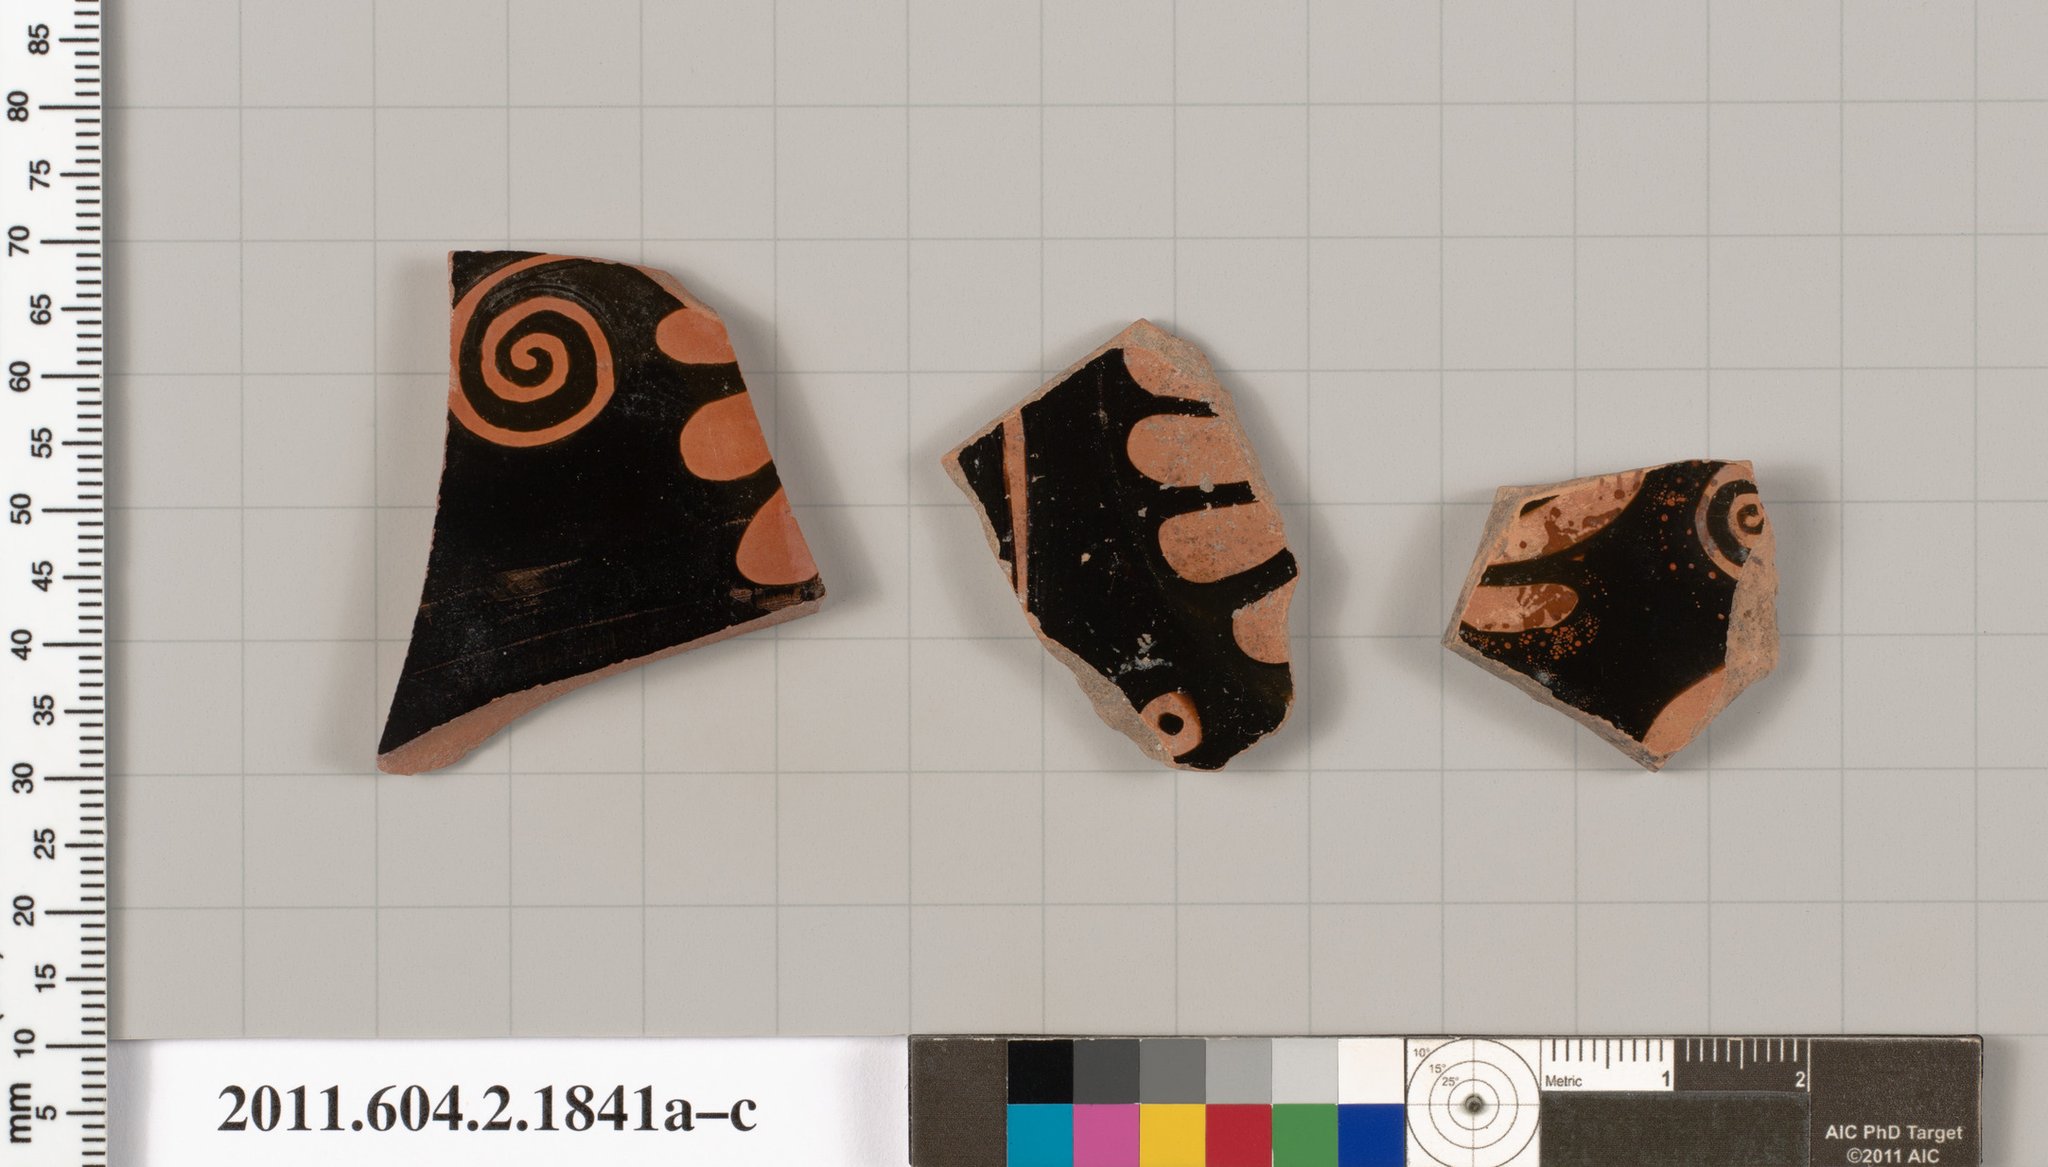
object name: skyphos fragment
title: Terracotta fragments of skyphoi (deep drinking cups)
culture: greek, attic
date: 450-430 BCE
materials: terracotta